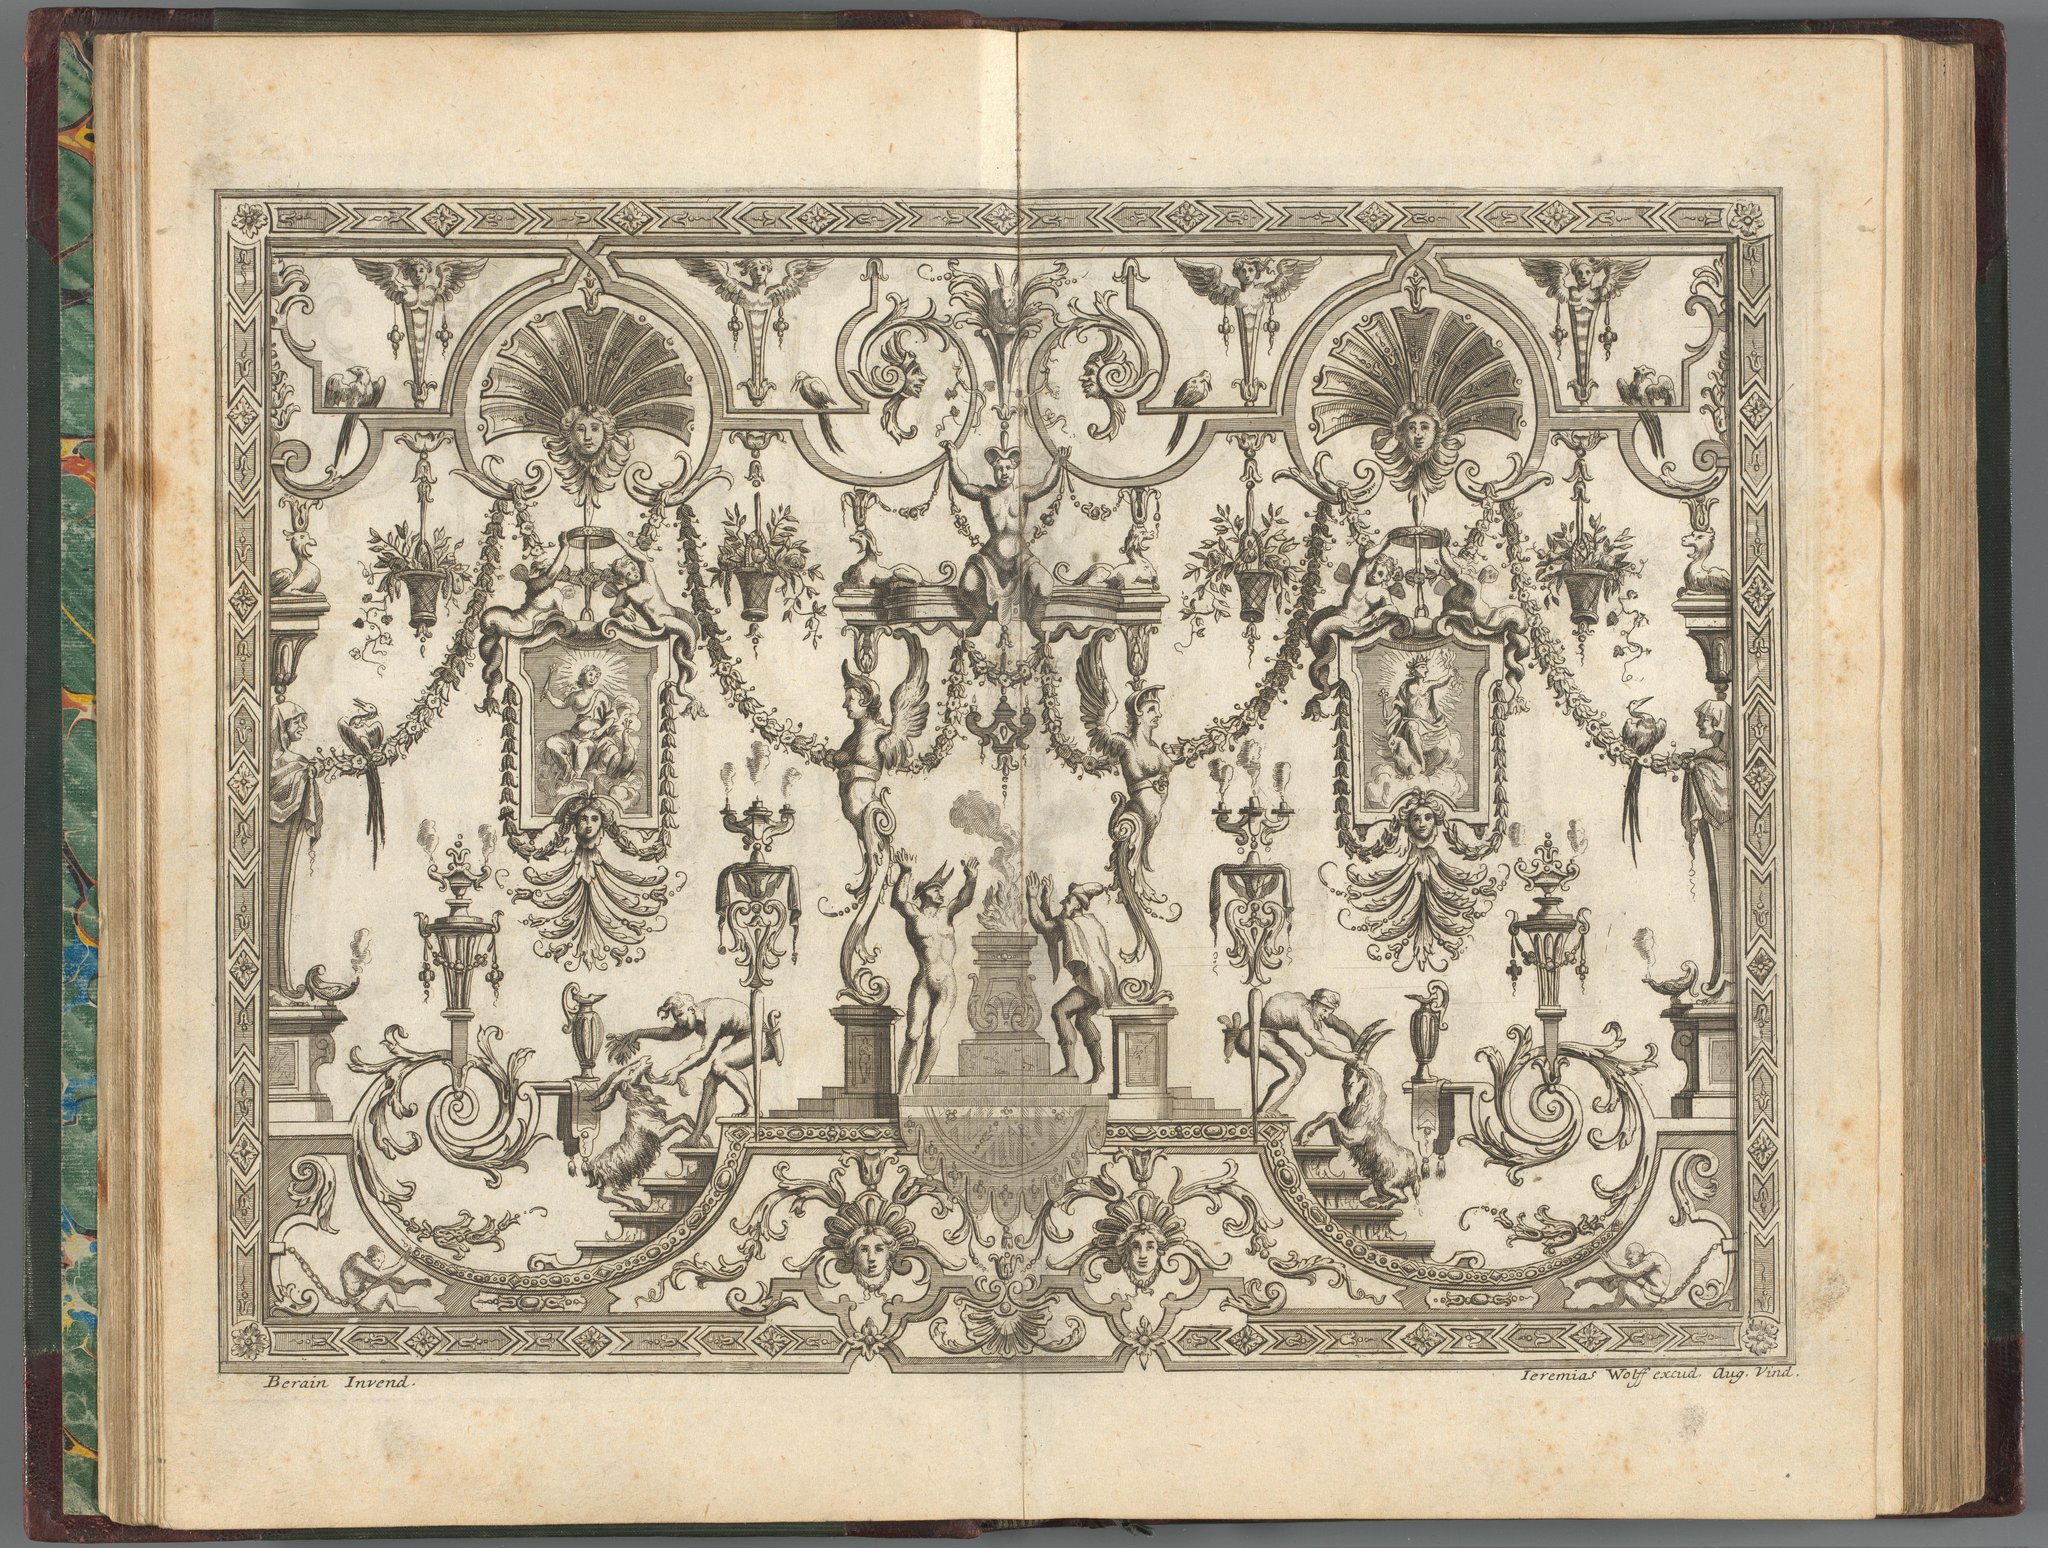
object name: ornament print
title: Panelen met grotesken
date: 1686-1724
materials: paper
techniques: etching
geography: augsburg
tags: ornaments ~ art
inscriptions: signature: ‘Berain Invend.’, signature: ‘Ieremias Wolff excud. Aug. Vind.’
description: Paneel of wandtapijt met in het midden een offerscène van twee dansende mannen rondom een vuur. Links en rechts wordt een geit een trap opgetrokken. Prent maakt deel uit van een album. Hoogstwaarschijnlijk gespiegelde kopie naar Frans origineel.